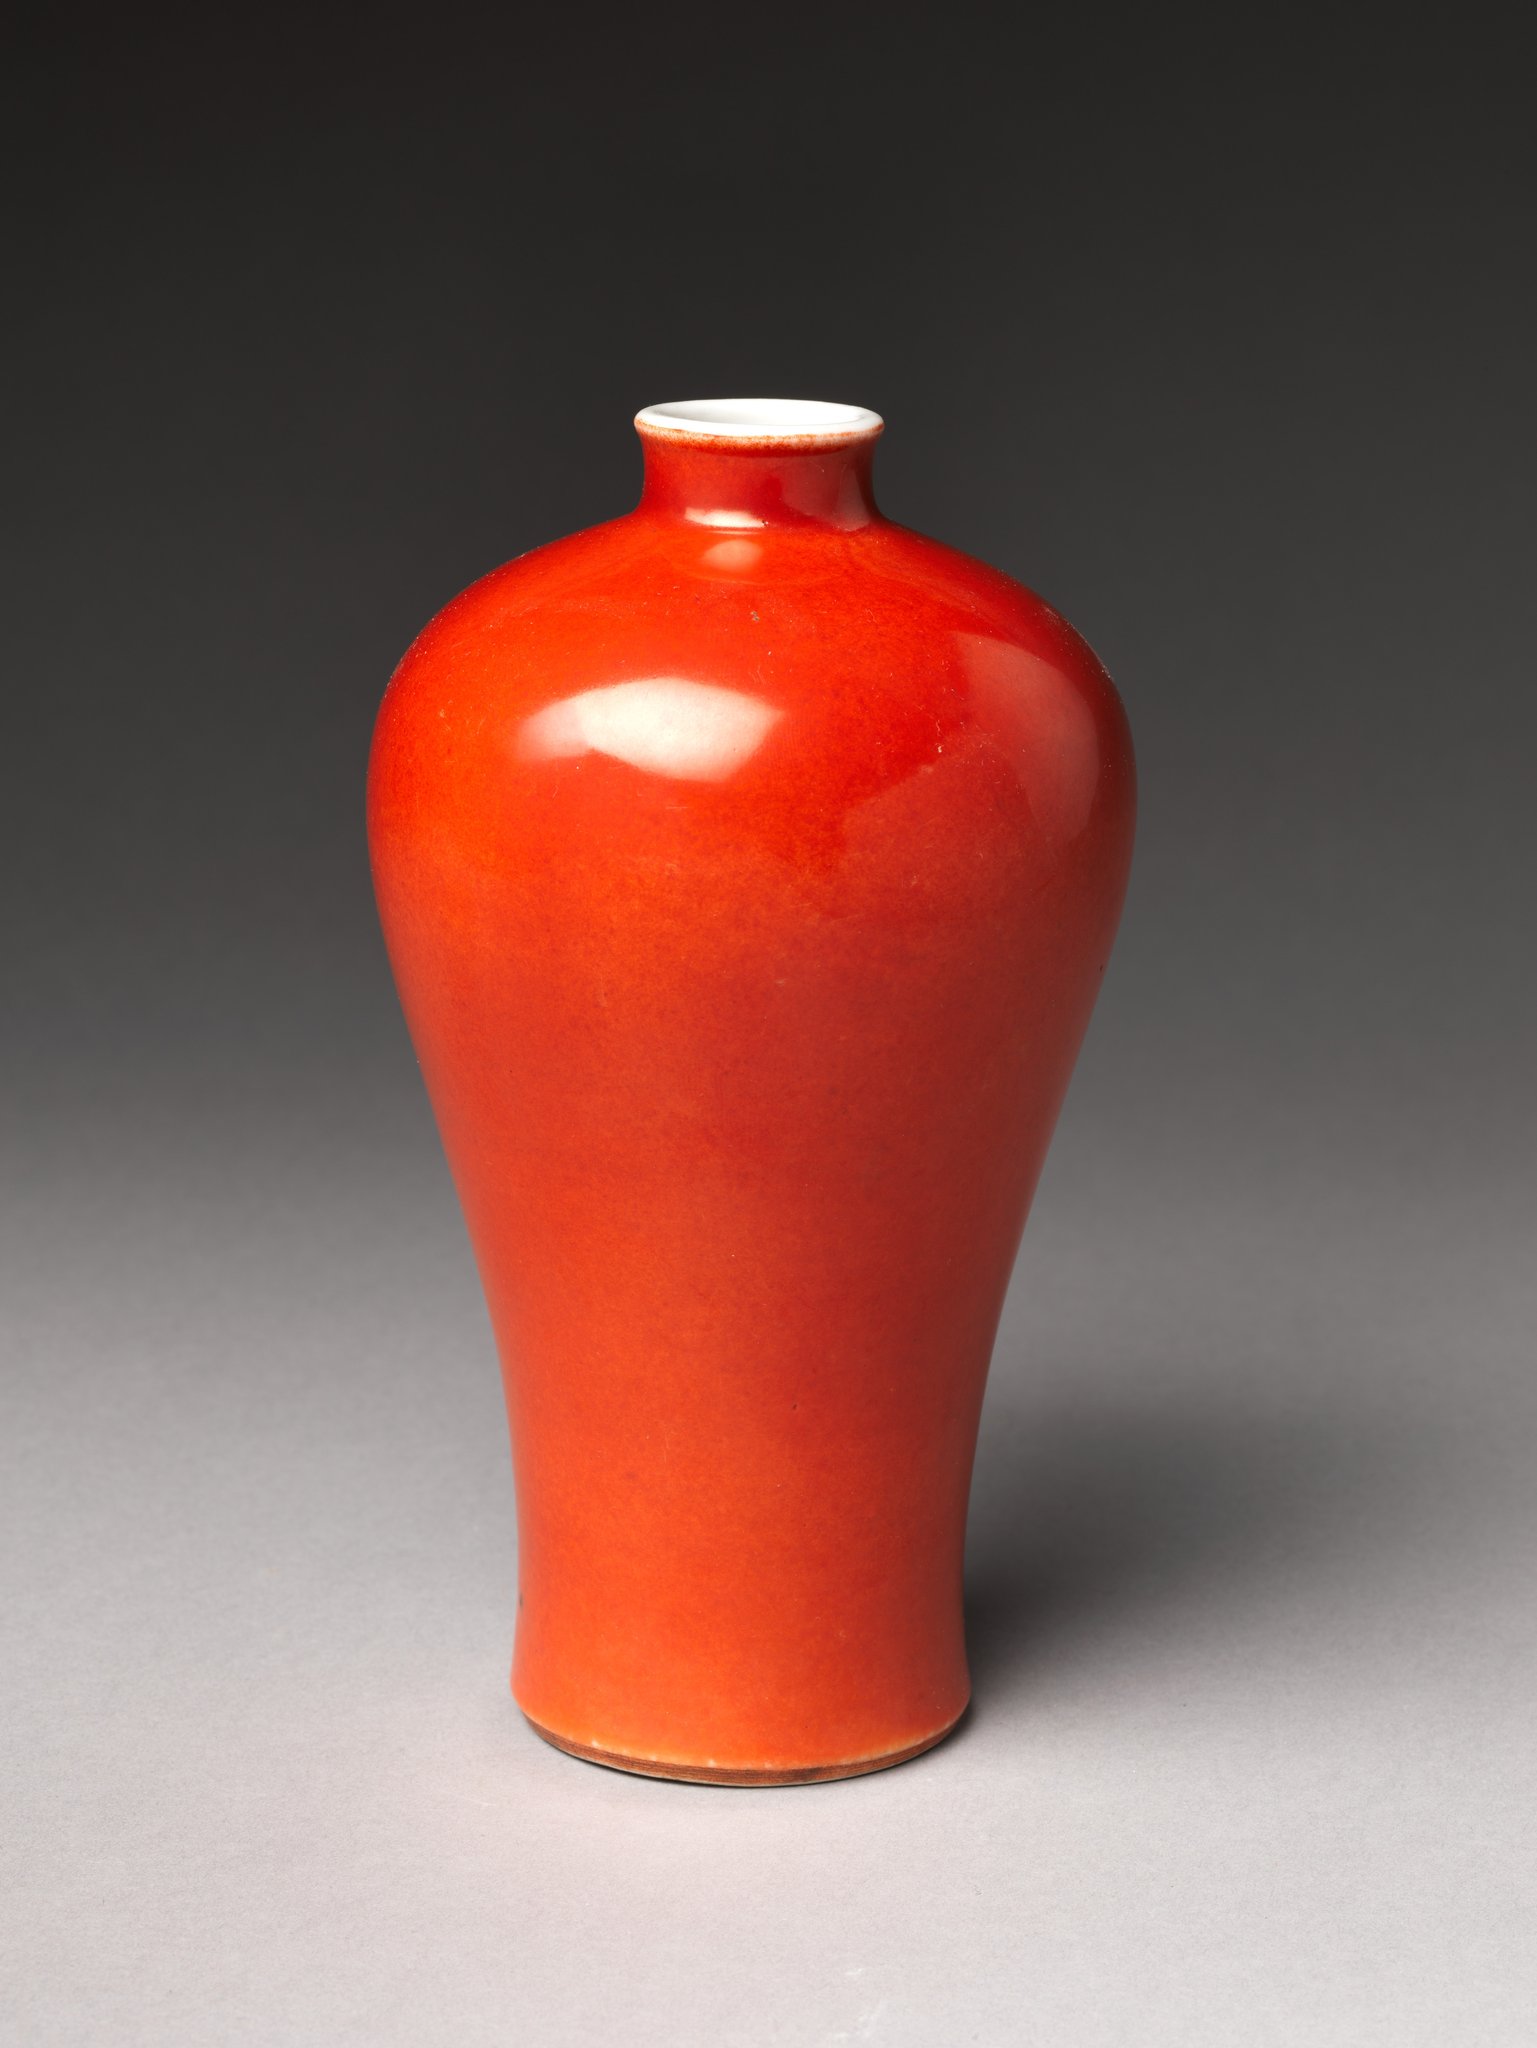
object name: vase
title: Vase in Meiping Shape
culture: chinese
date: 1767-1833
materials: coral, glaze, porcelain